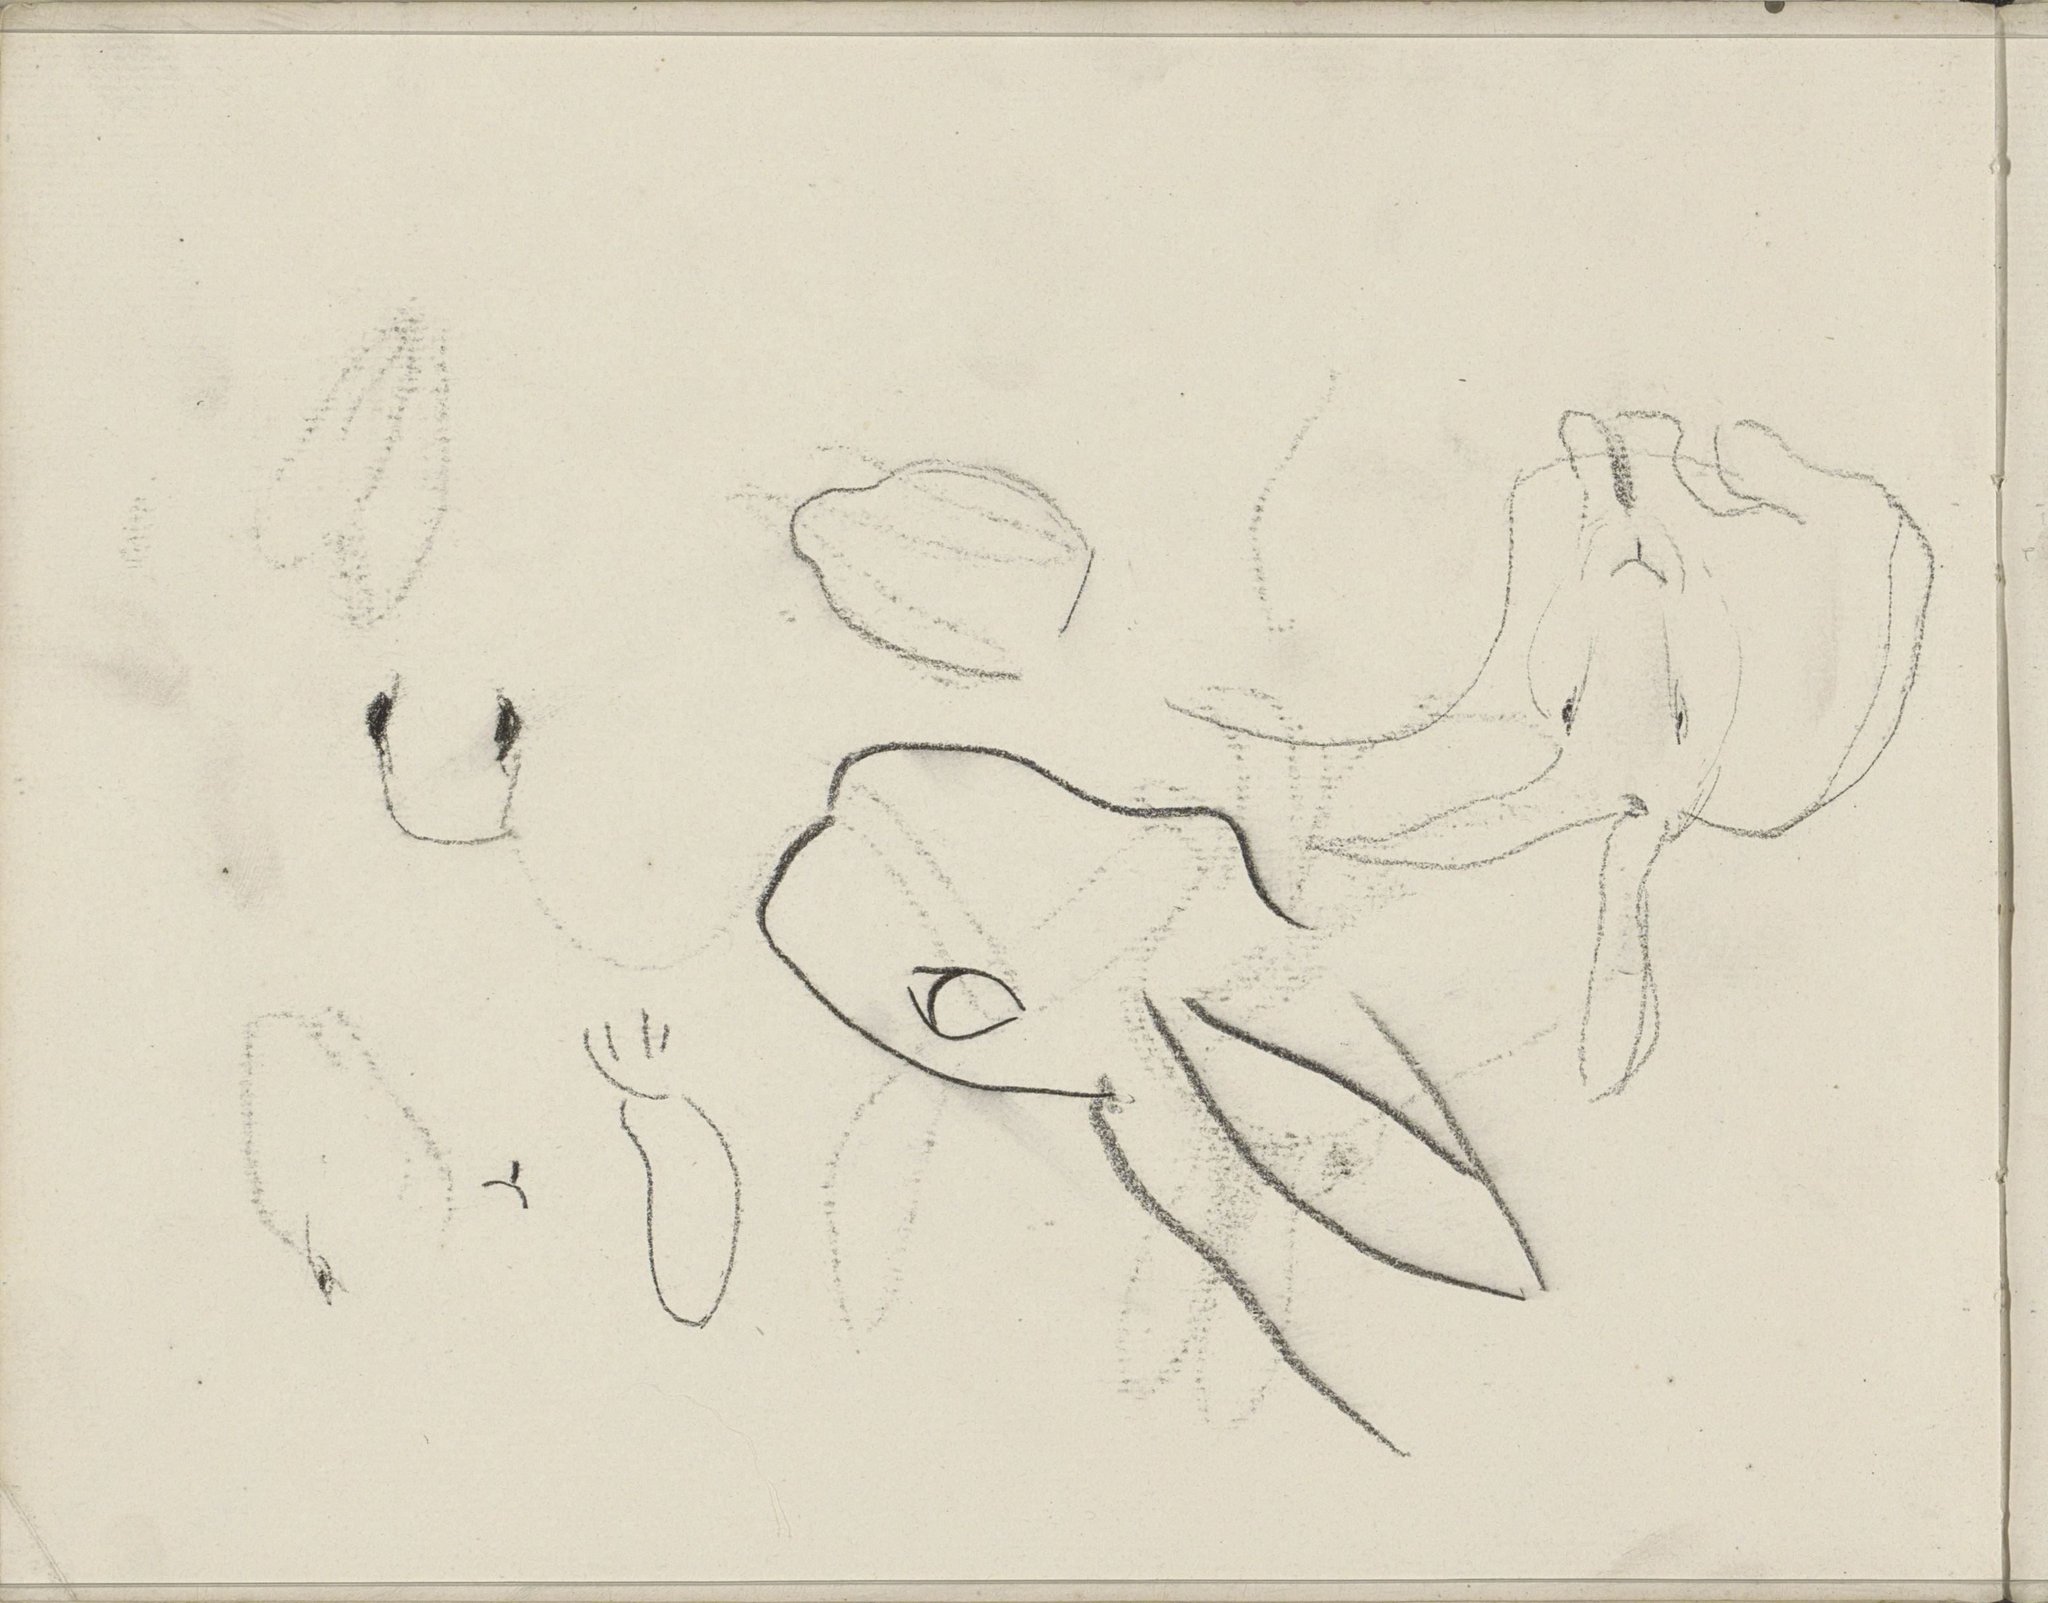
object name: sketchbook leaf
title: Konijn en een kop van een konijn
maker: carel adolph lion cachet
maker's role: draughtsman, print maker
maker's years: 1864-1945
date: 1896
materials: chalk, paper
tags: rodents: rabbit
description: Blad 40 verso uit een schetsboek met 44 bladen.